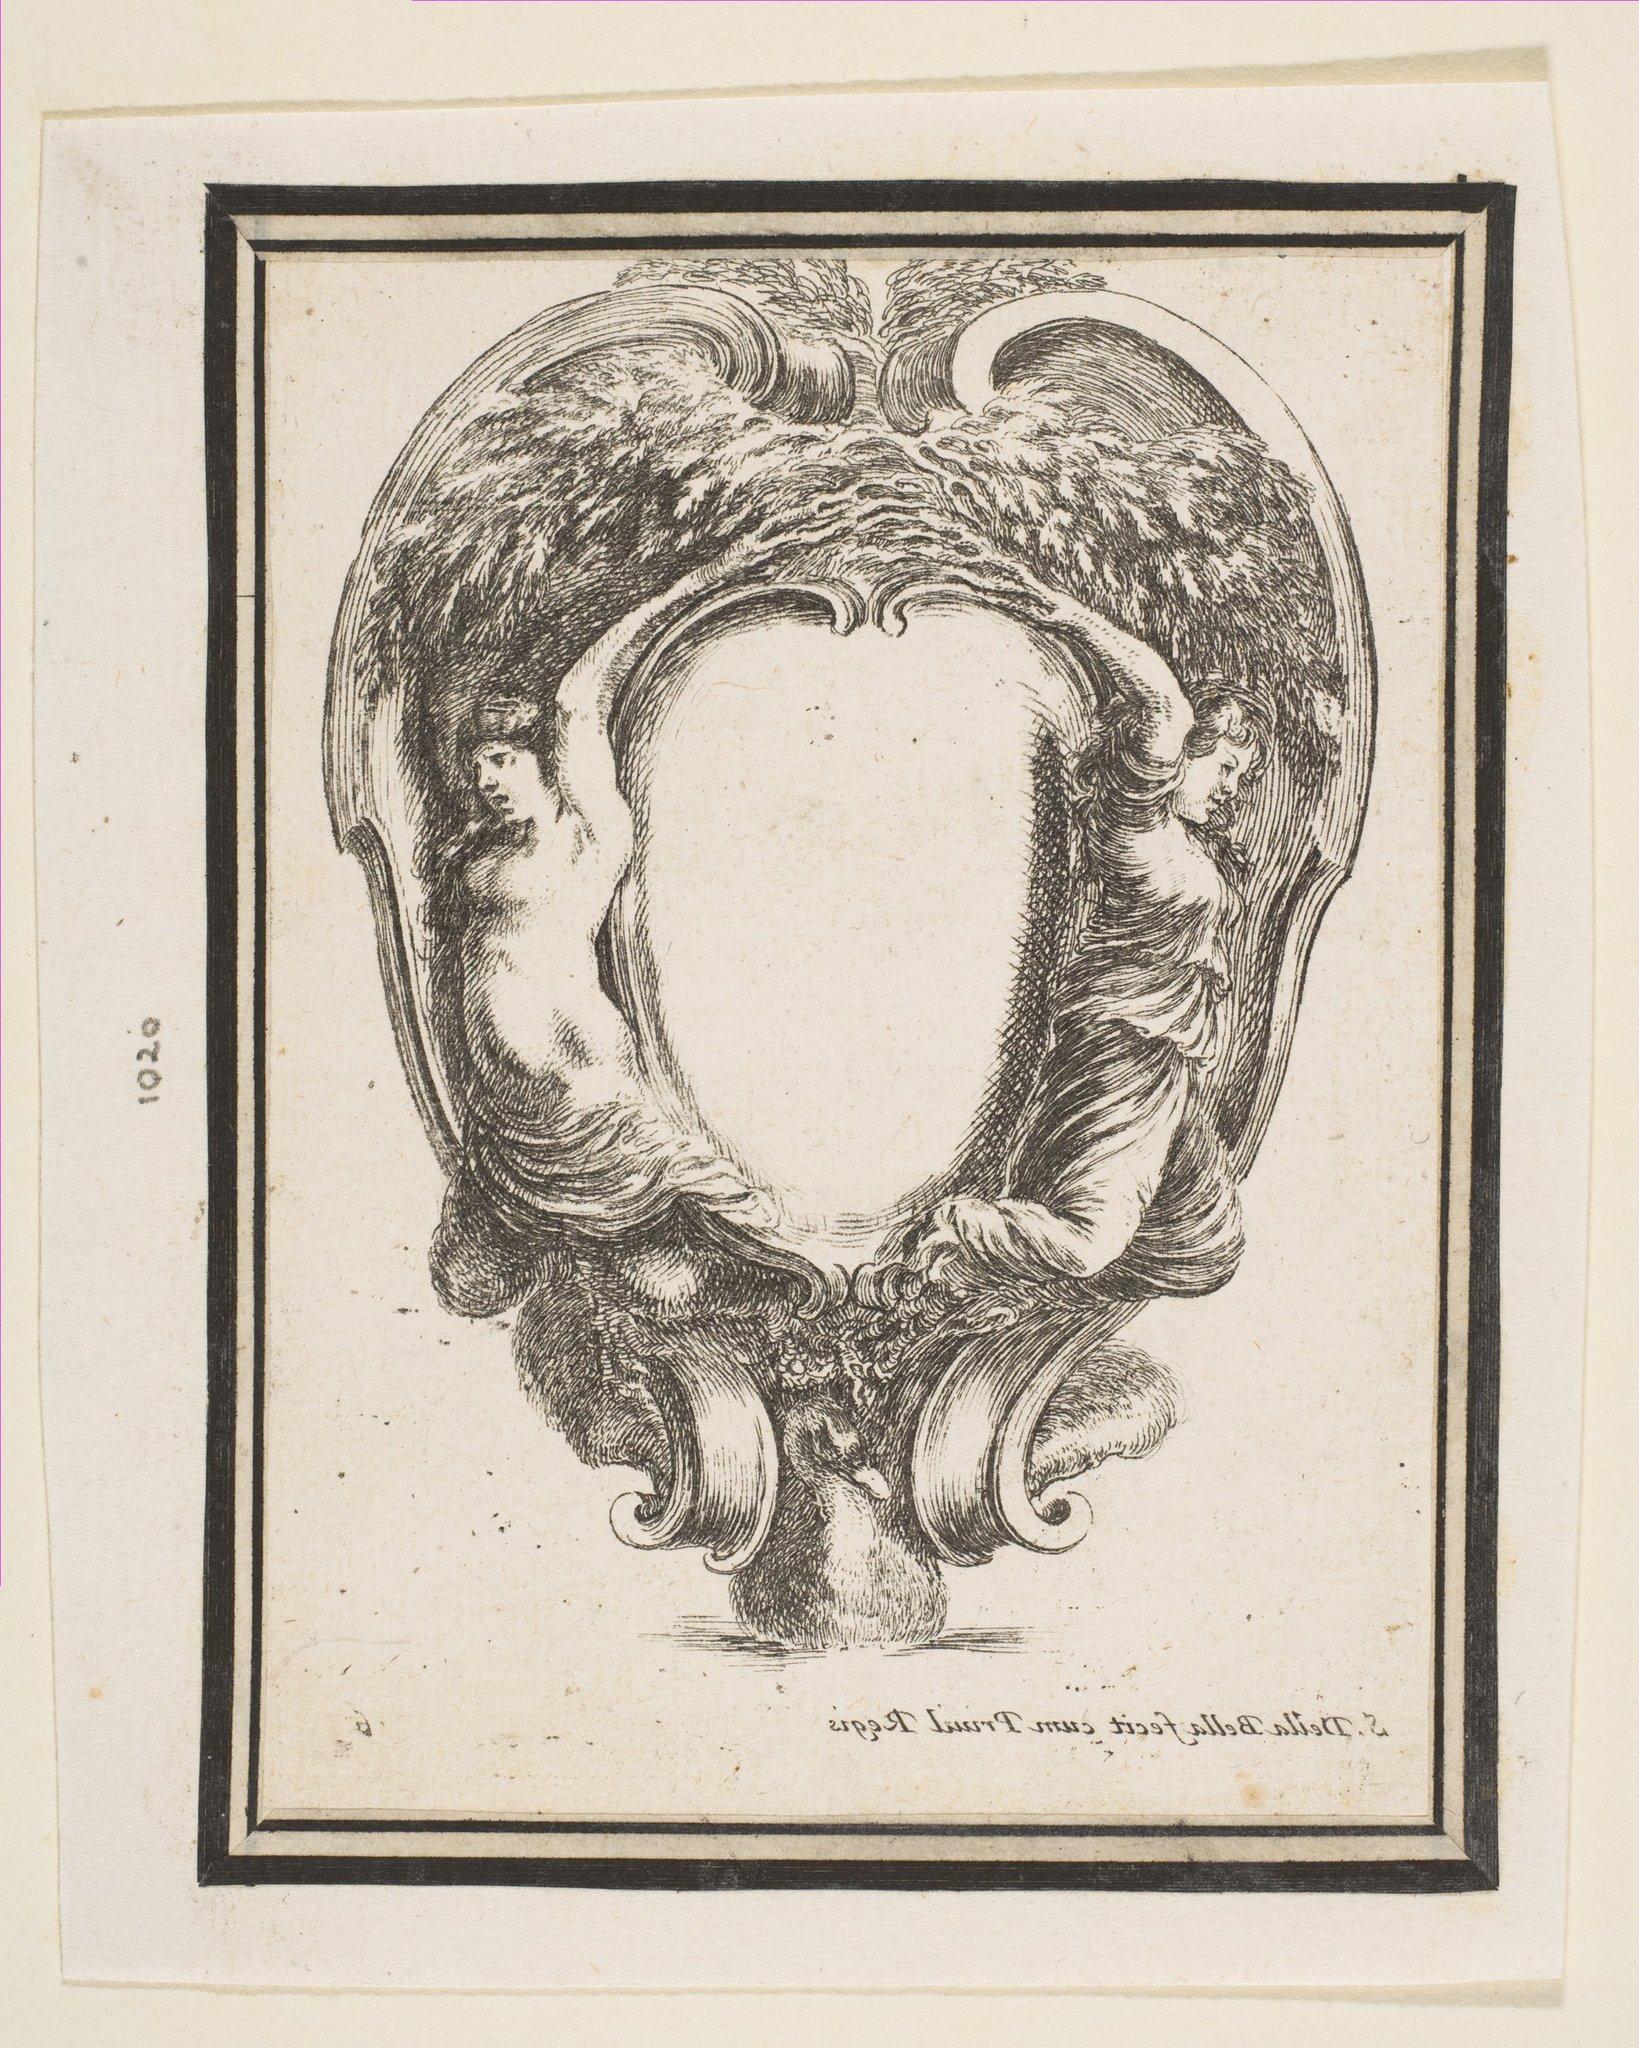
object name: print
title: Cartouche with Duck and Nymphs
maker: stefano della bella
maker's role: artist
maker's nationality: italian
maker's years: 1610-1664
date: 1647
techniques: printmaking, etching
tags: ducks,cartouches,nymphs